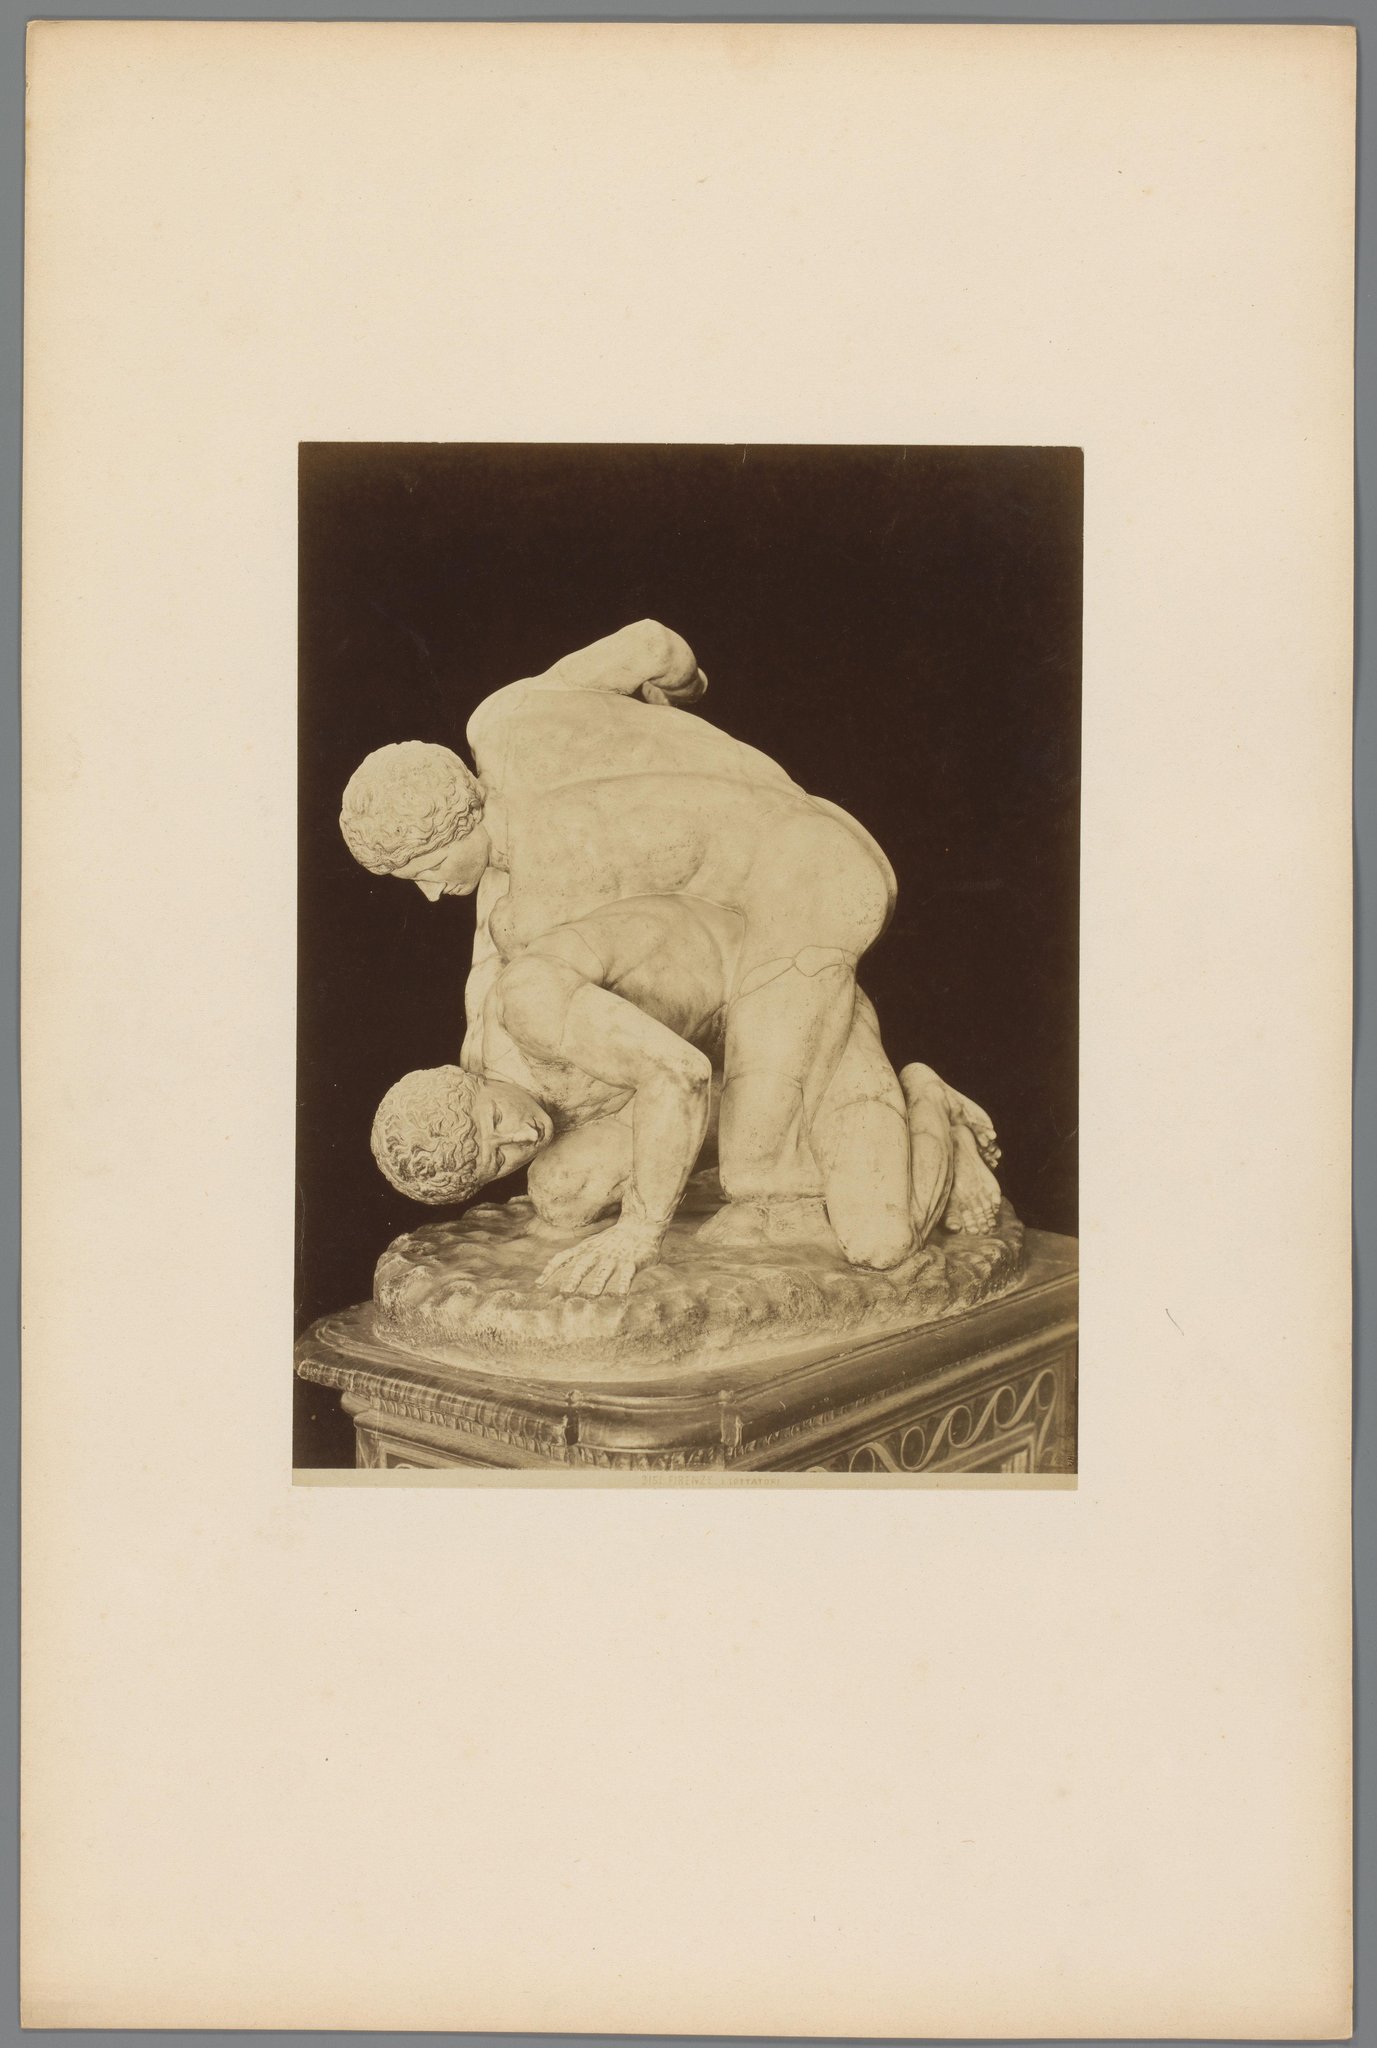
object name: photograph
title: Lottatori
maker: Anonymous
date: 1851-1900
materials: cardboard, paper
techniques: albumen print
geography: florence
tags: wrestling (sport), piece of sculpture, reproduction of a piece of sculpture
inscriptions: number: ‘3151’